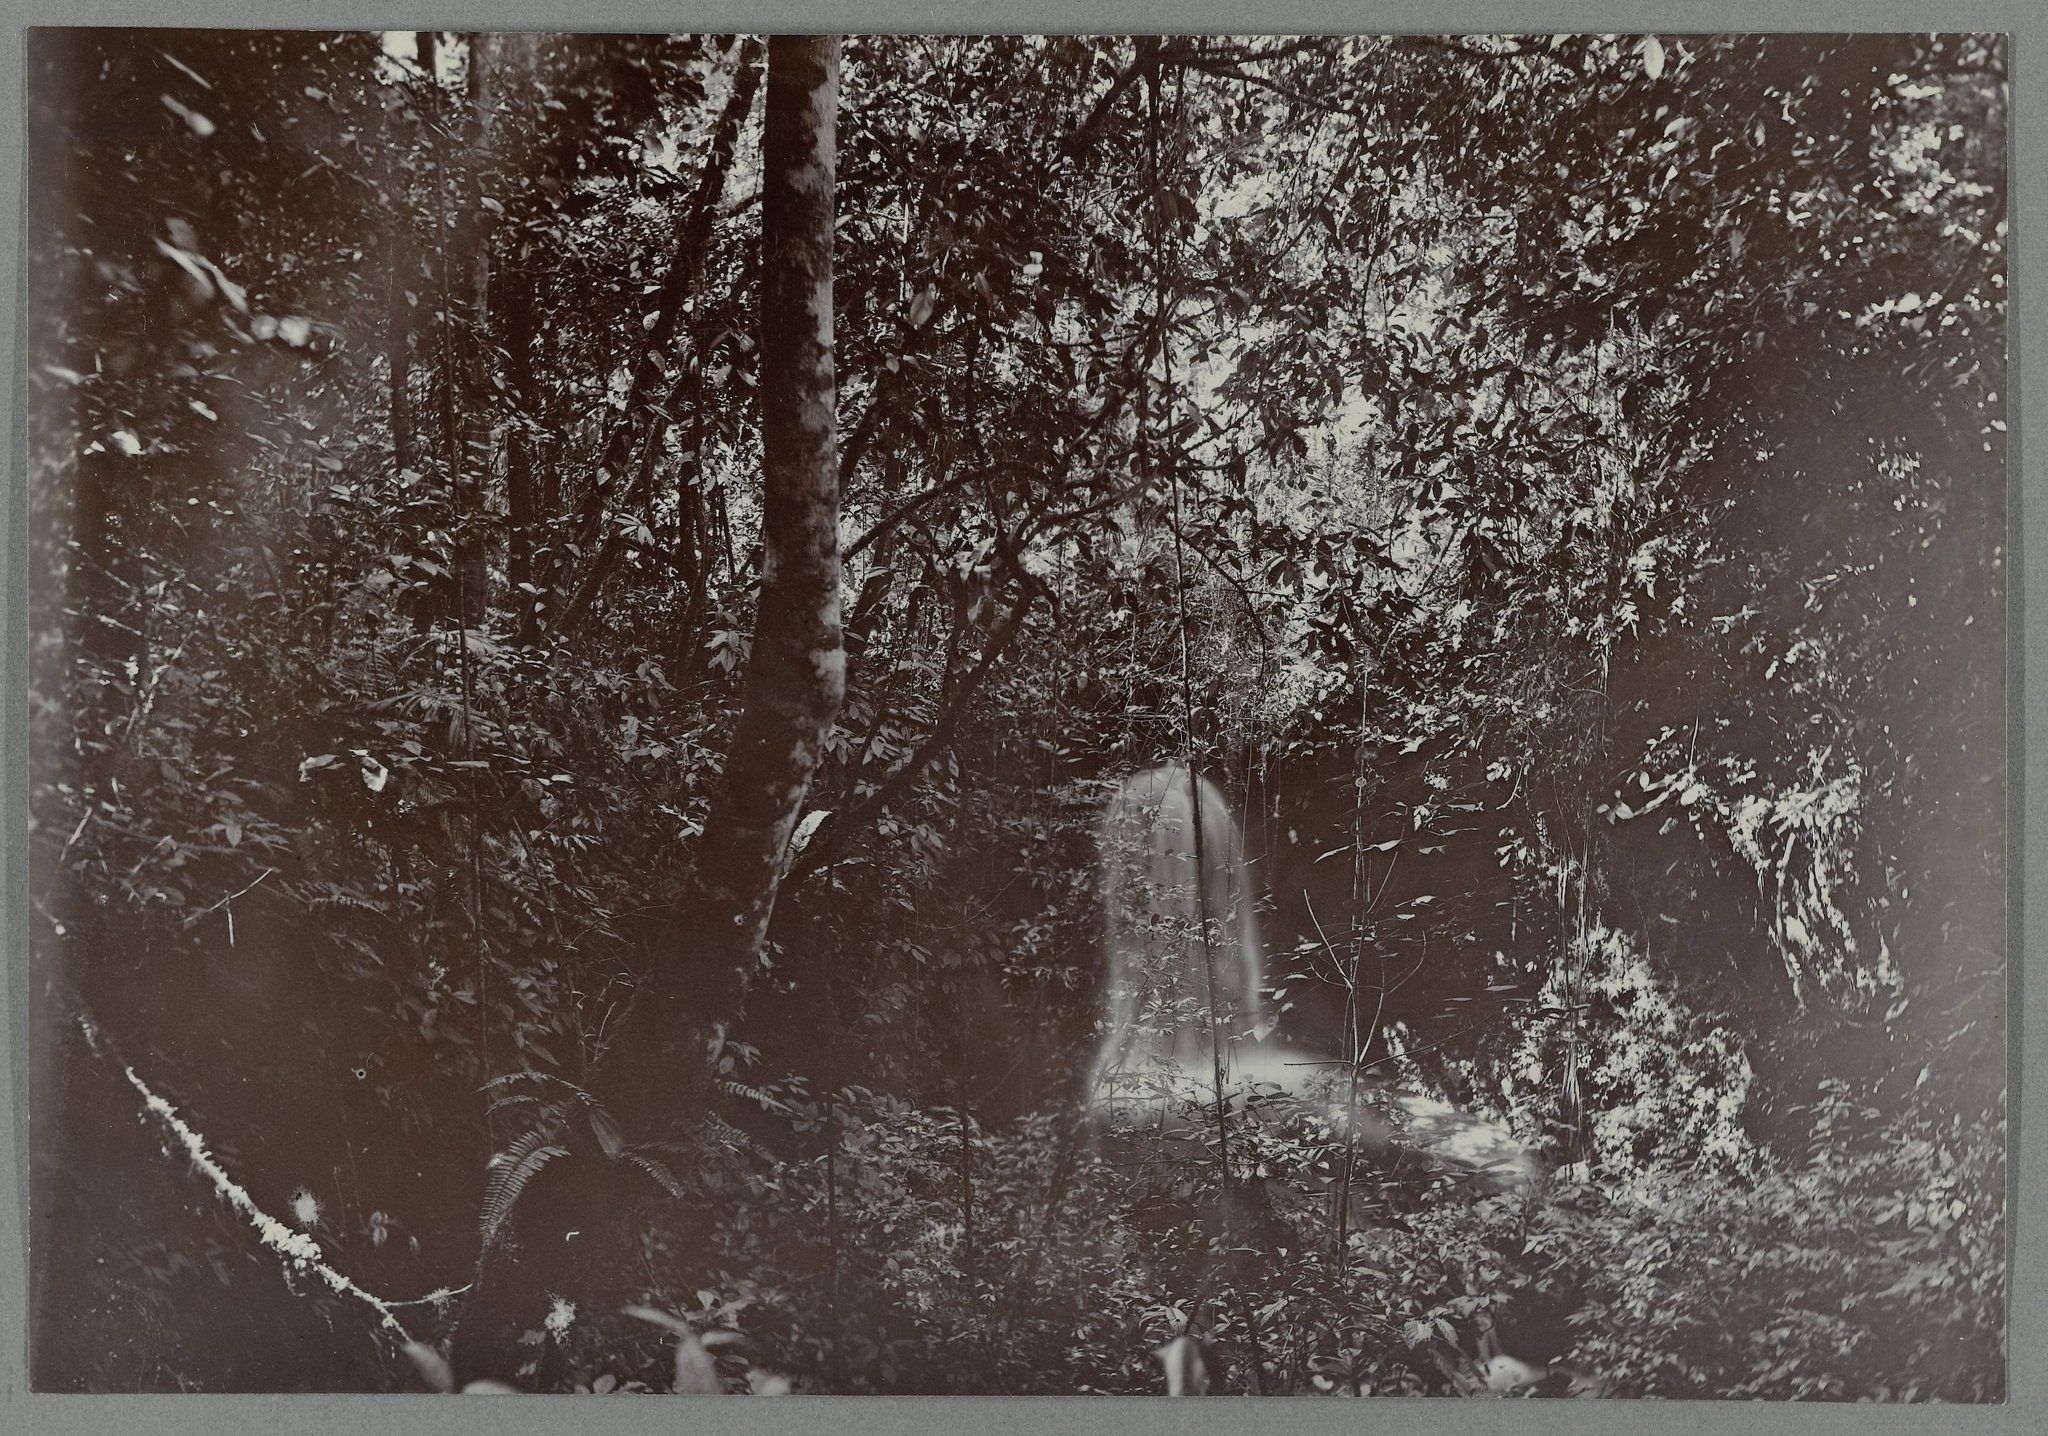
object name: photograph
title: Waterval in het bos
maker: Anonymous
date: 1903-1913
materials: photographic support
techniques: photography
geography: north sumatra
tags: albertus dominicus laman trip, waterfall, road, path, jungle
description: Na de expedities naar de Gajo- en Alaslanden o.l.v. Van Daalen (eerste tocht in 1901), werd hij in 1903 belast met voorbereiding van permanente vestiging van Nederlands gezag. Aanleg van een weg van de Noordkust naar het binnenland was hierbij van groot belang. Deze zgn. Gajoweg werd aangelegd tussen 1903 en 1914, van Bireuen aan de kust naar Takinguen aan het bergmeer Danau Lauttawar, totale lente 104 km.